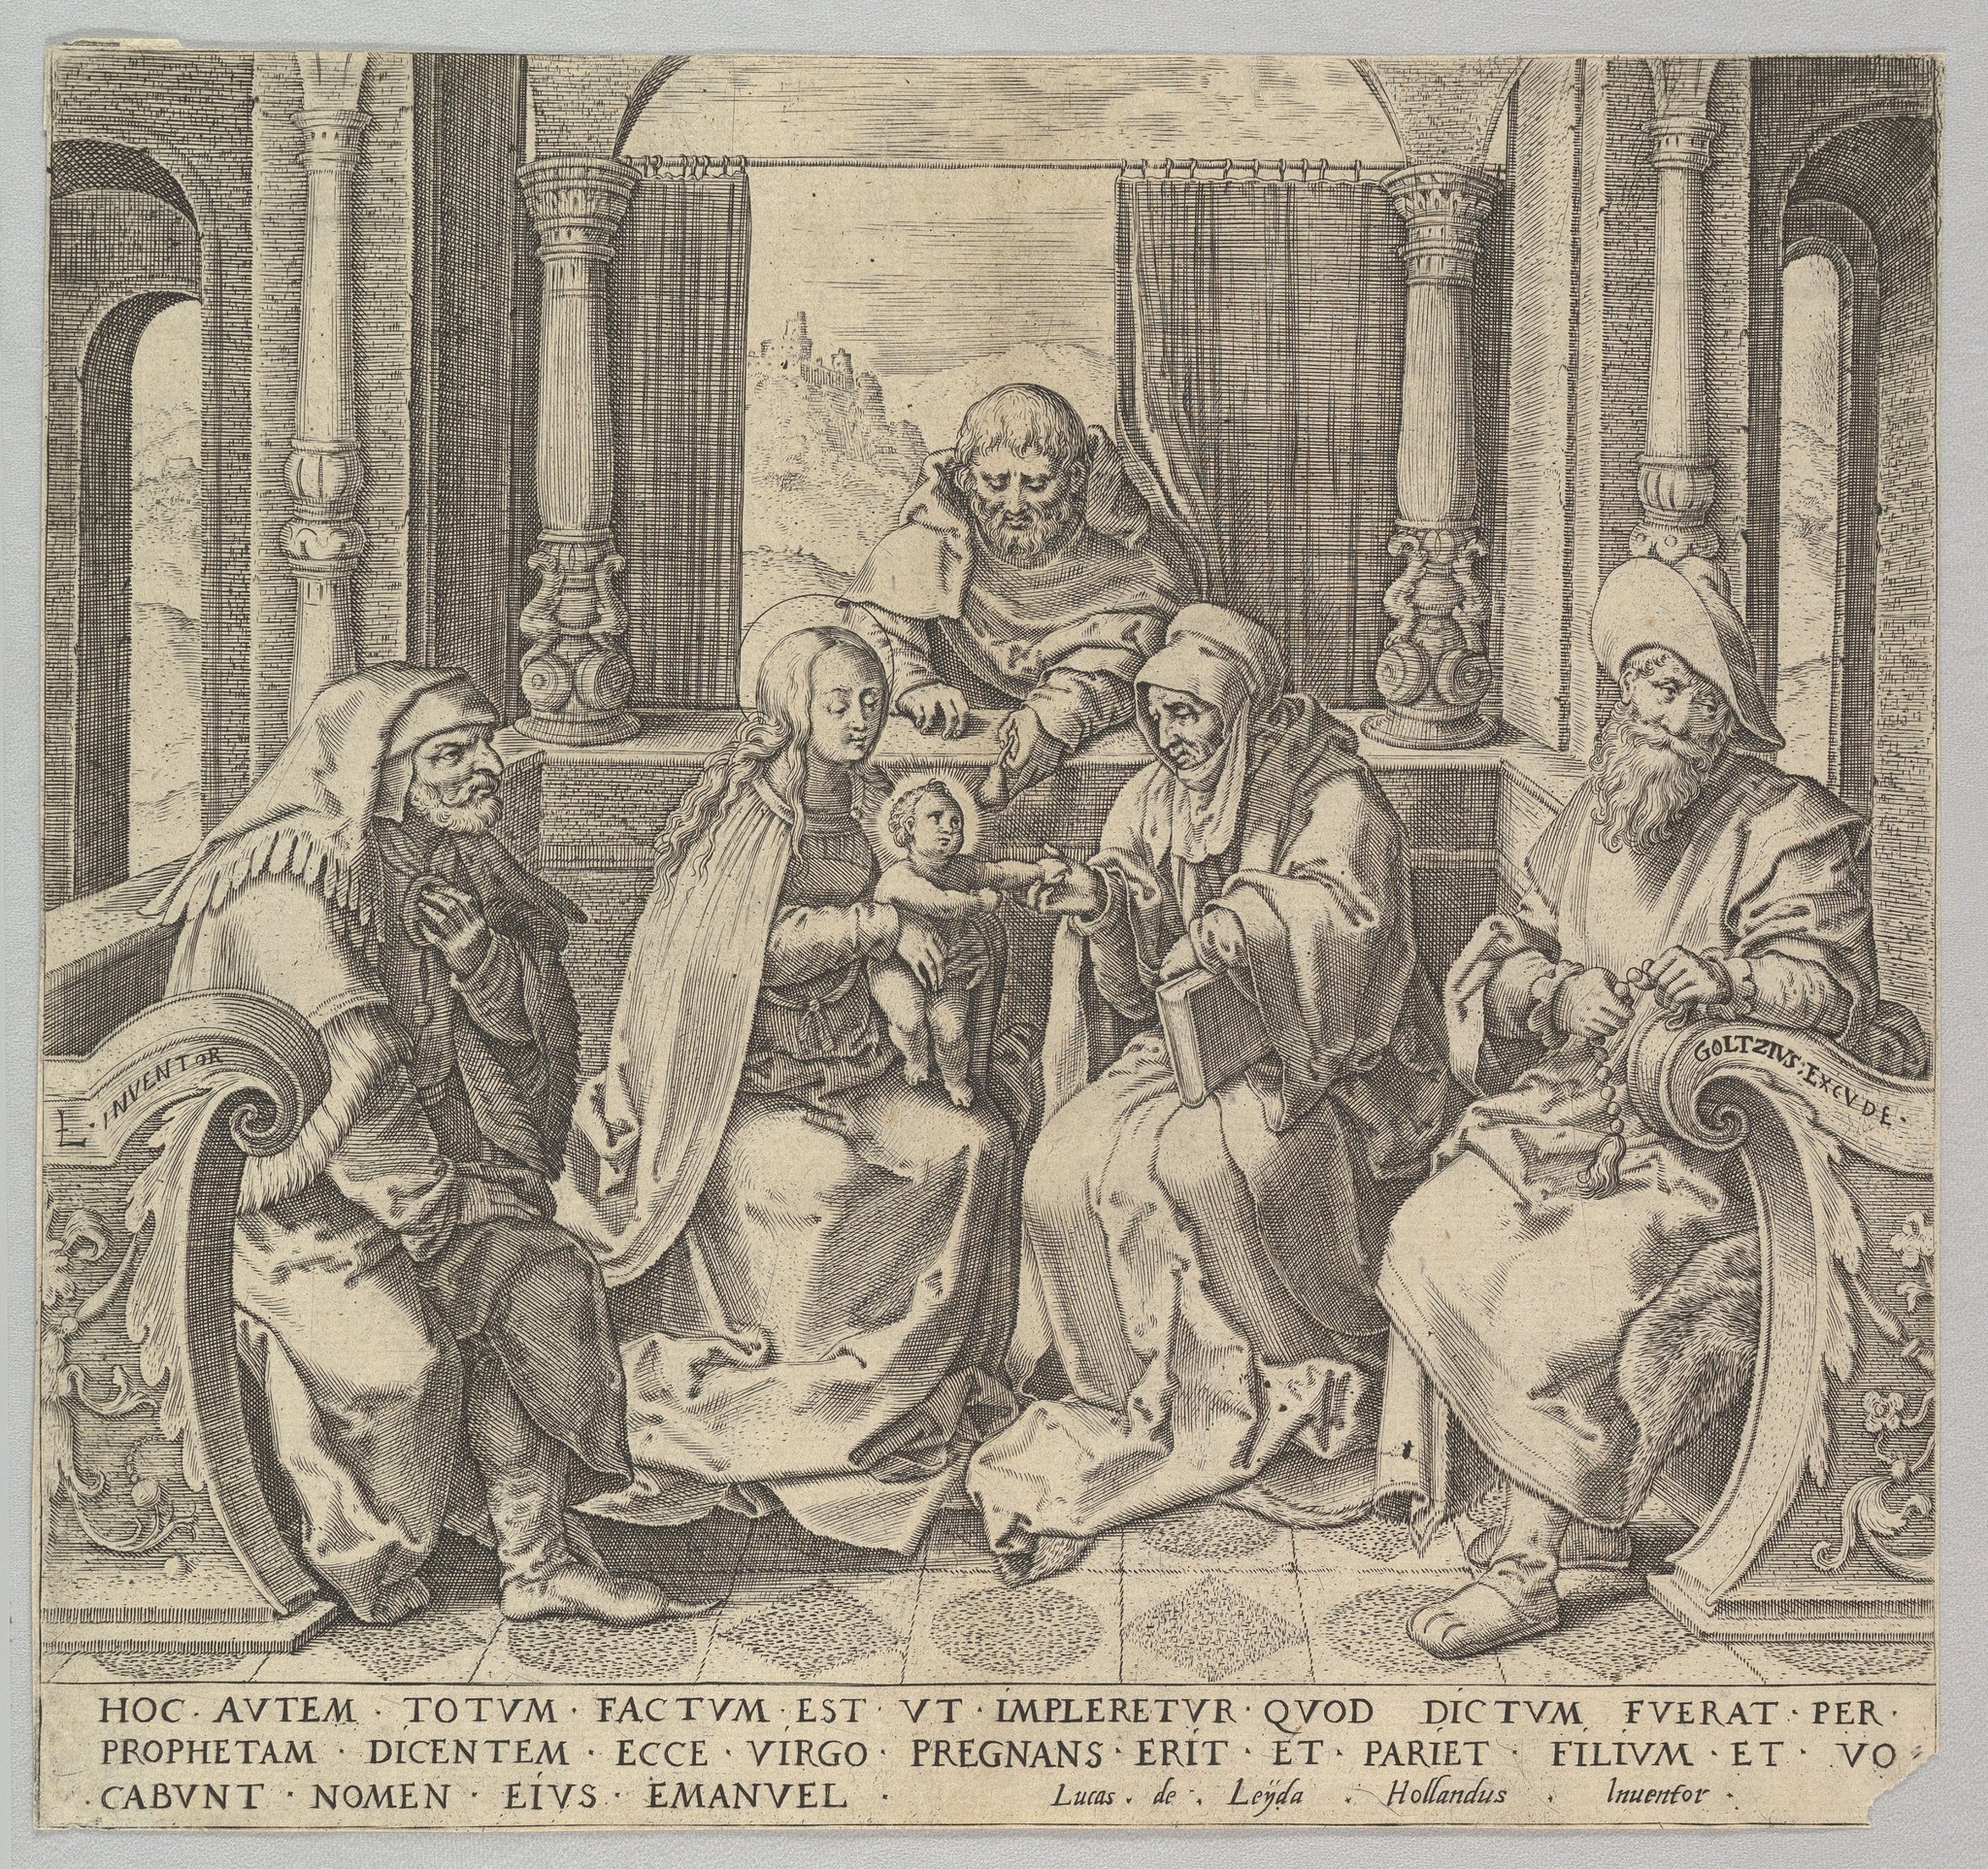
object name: print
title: The Holy Kindred, (Virgin and Child with Joseph, Anne and Two Male Saints) (copy)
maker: lucas van leyden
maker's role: artist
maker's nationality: netherlandish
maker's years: 1494-1533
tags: madonna and child,saint anne,saint joseph,saints